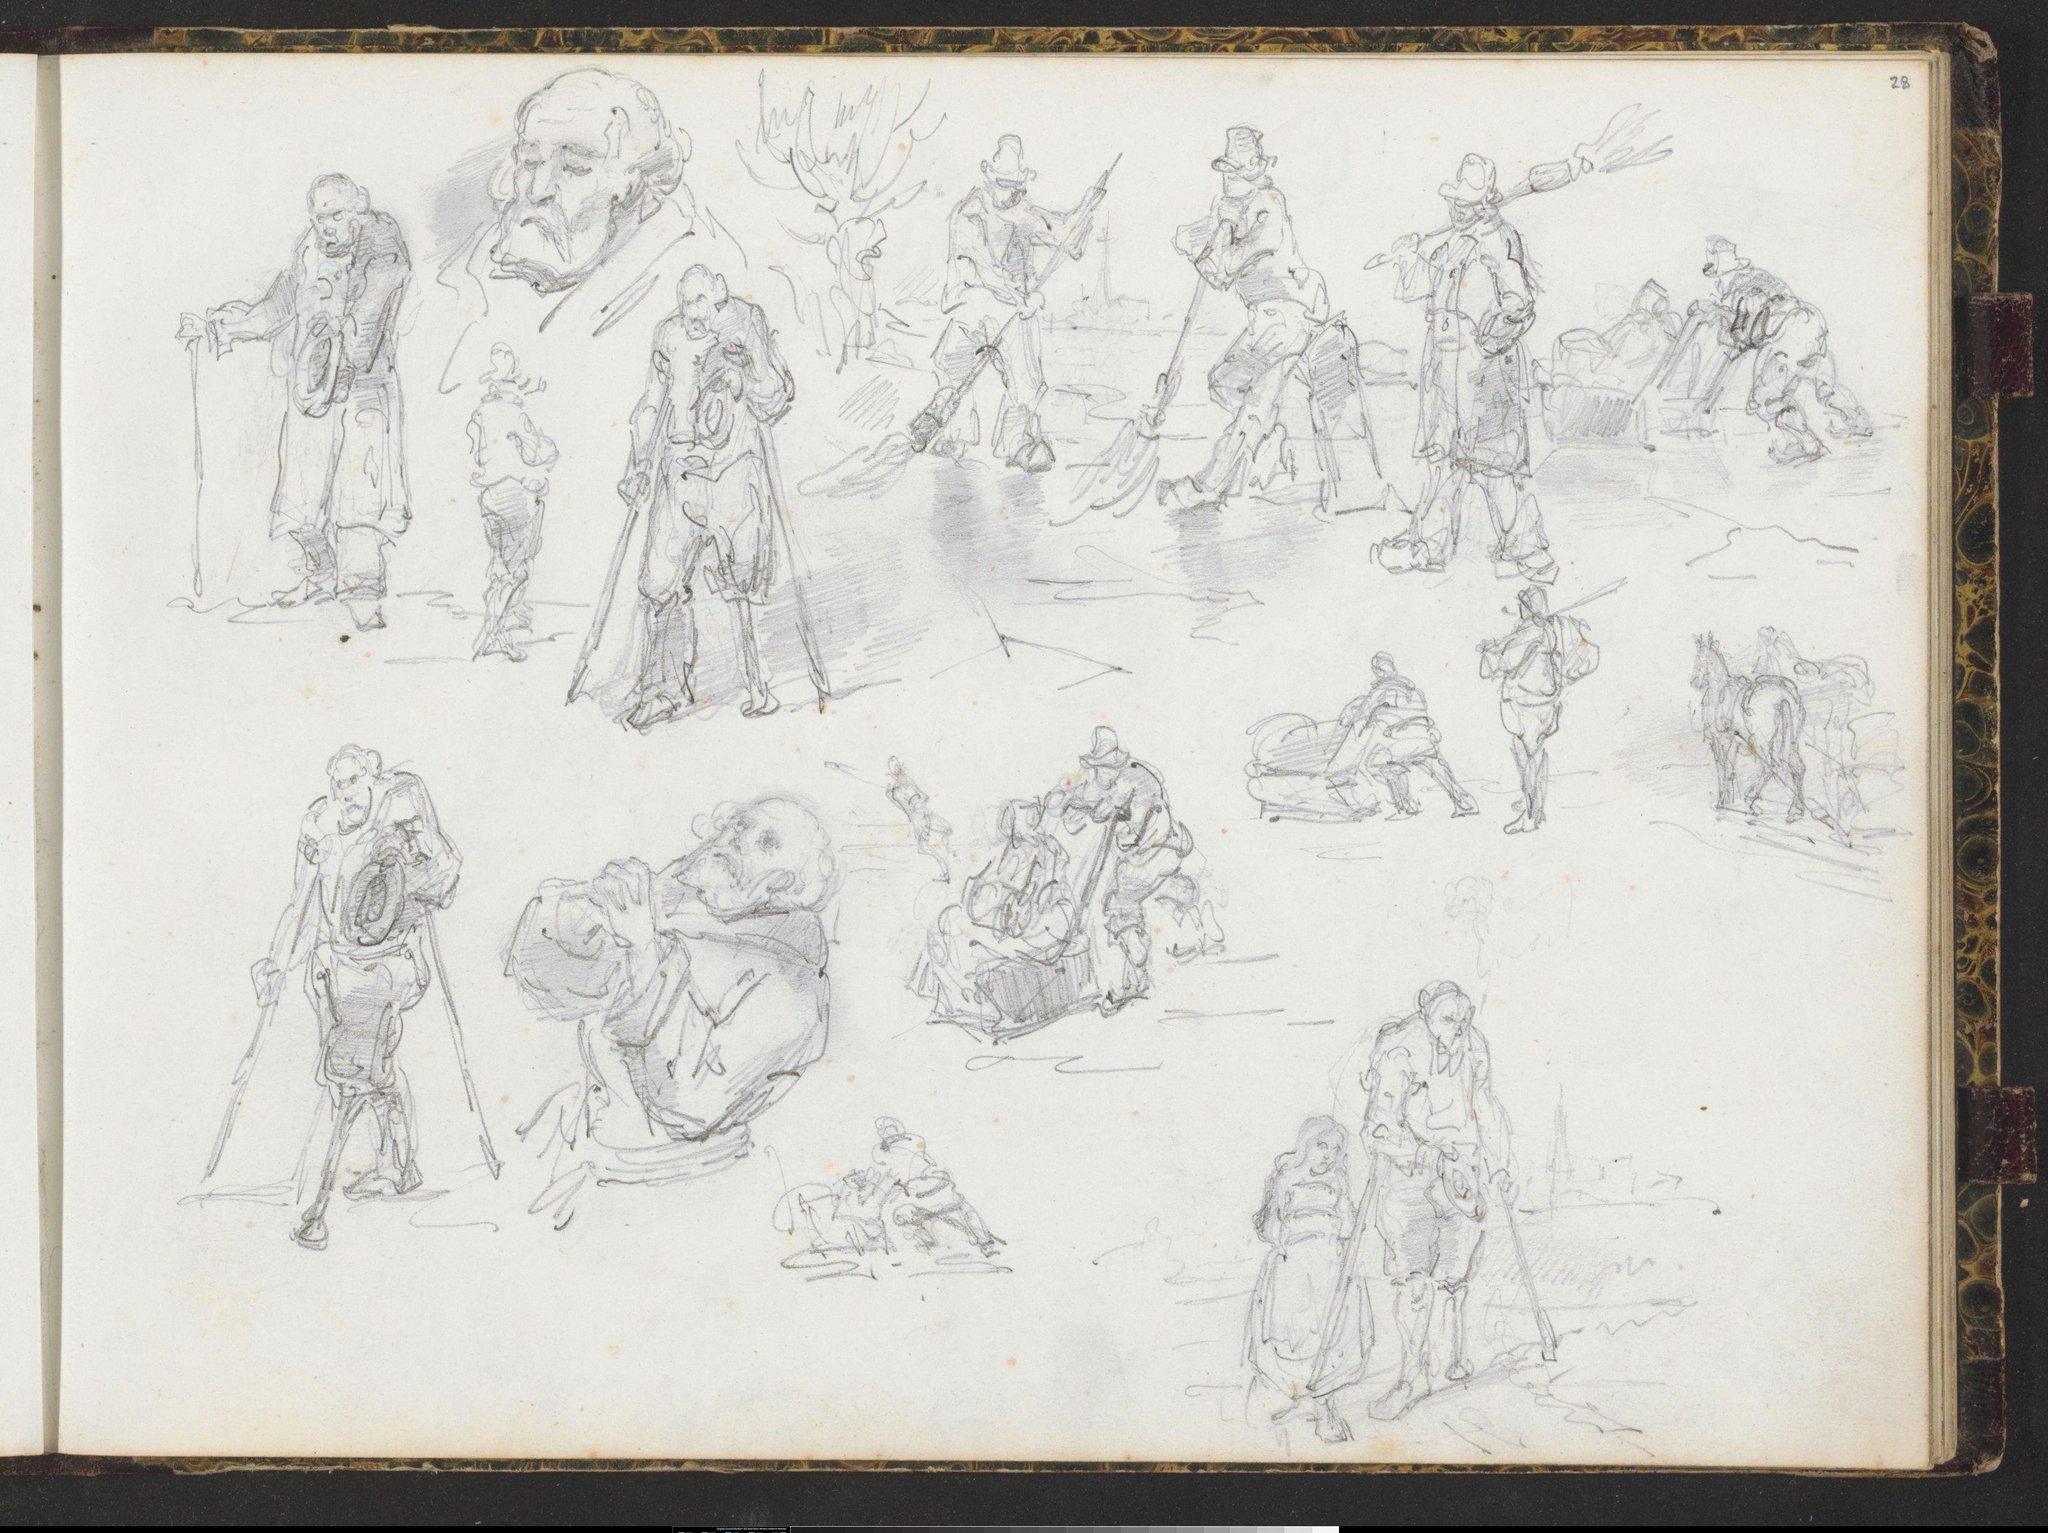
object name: sketchbook leaf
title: Studieblad met ijspret, monniken en bedelaars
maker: lambertus lingeman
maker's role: draughtsman, painter, print maker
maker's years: 1829-1894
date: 1839-1894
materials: paper, pencil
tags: monk(s), friar(s), ice ~ freezing weather, sledge, sleigh (winter sports), beggar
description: Blad 28 recto uit een schetsboek met 51 bladen.